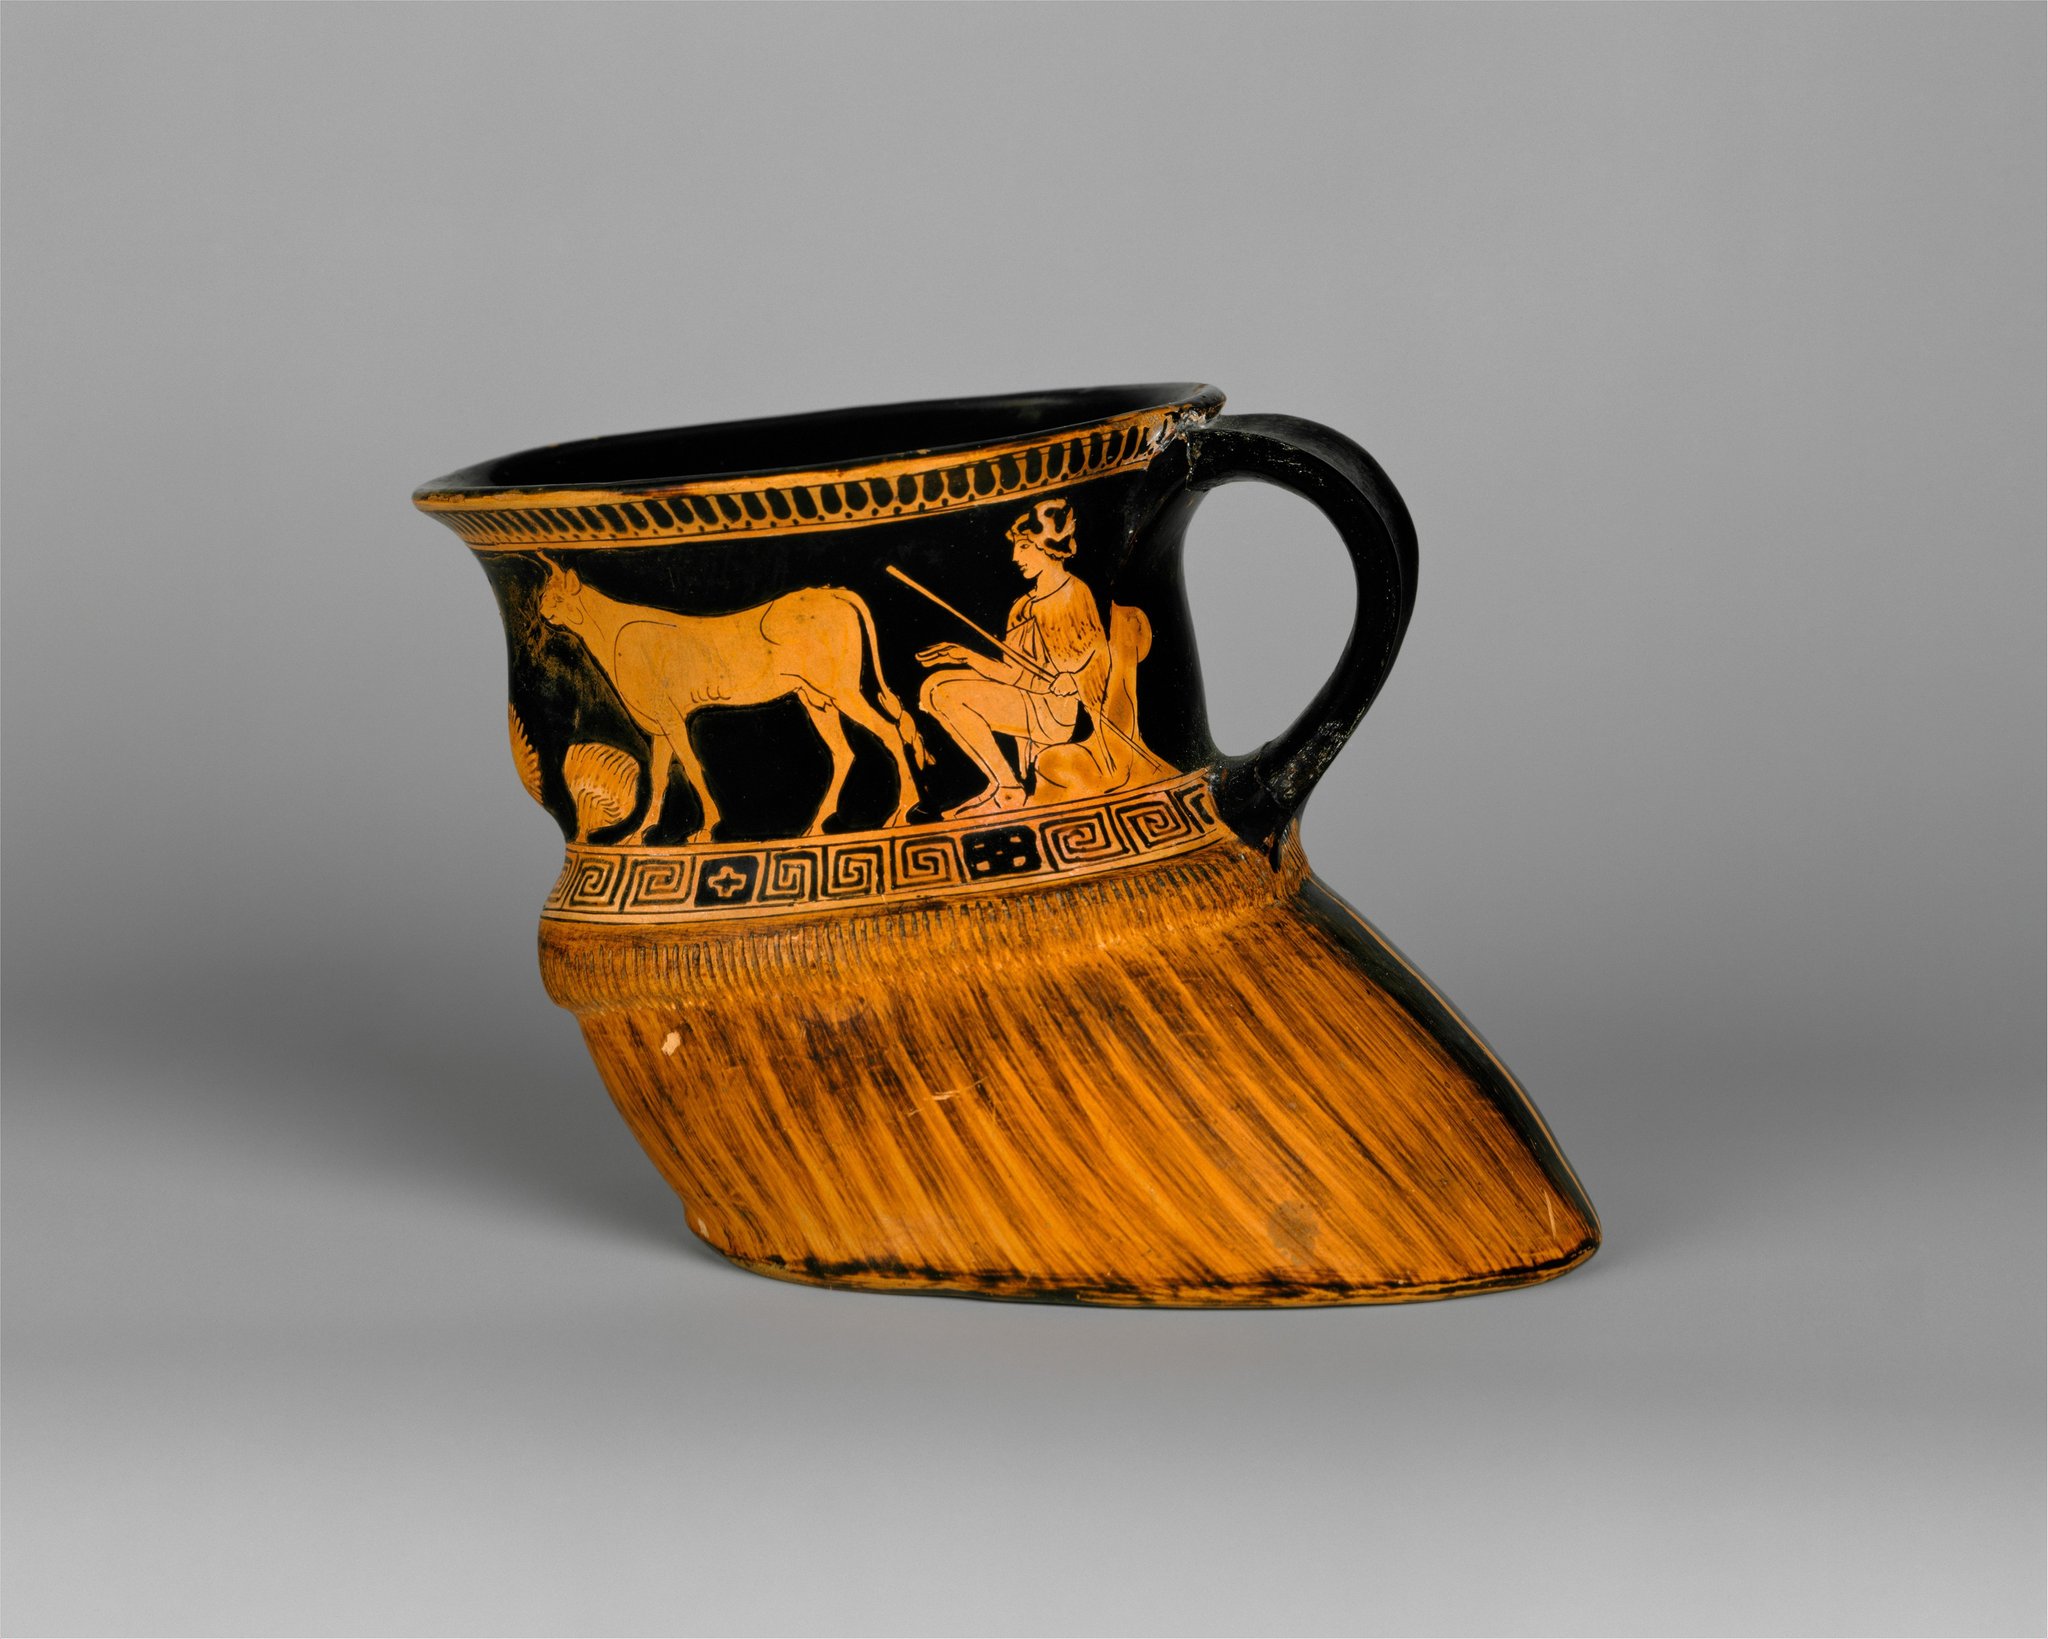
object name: cup in the form of a cow's hoof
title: Terracotta cup: cow's hoof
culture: greek, attic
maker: brygos painter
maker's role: artist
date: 470-460 BCE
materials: terracotta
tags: cows